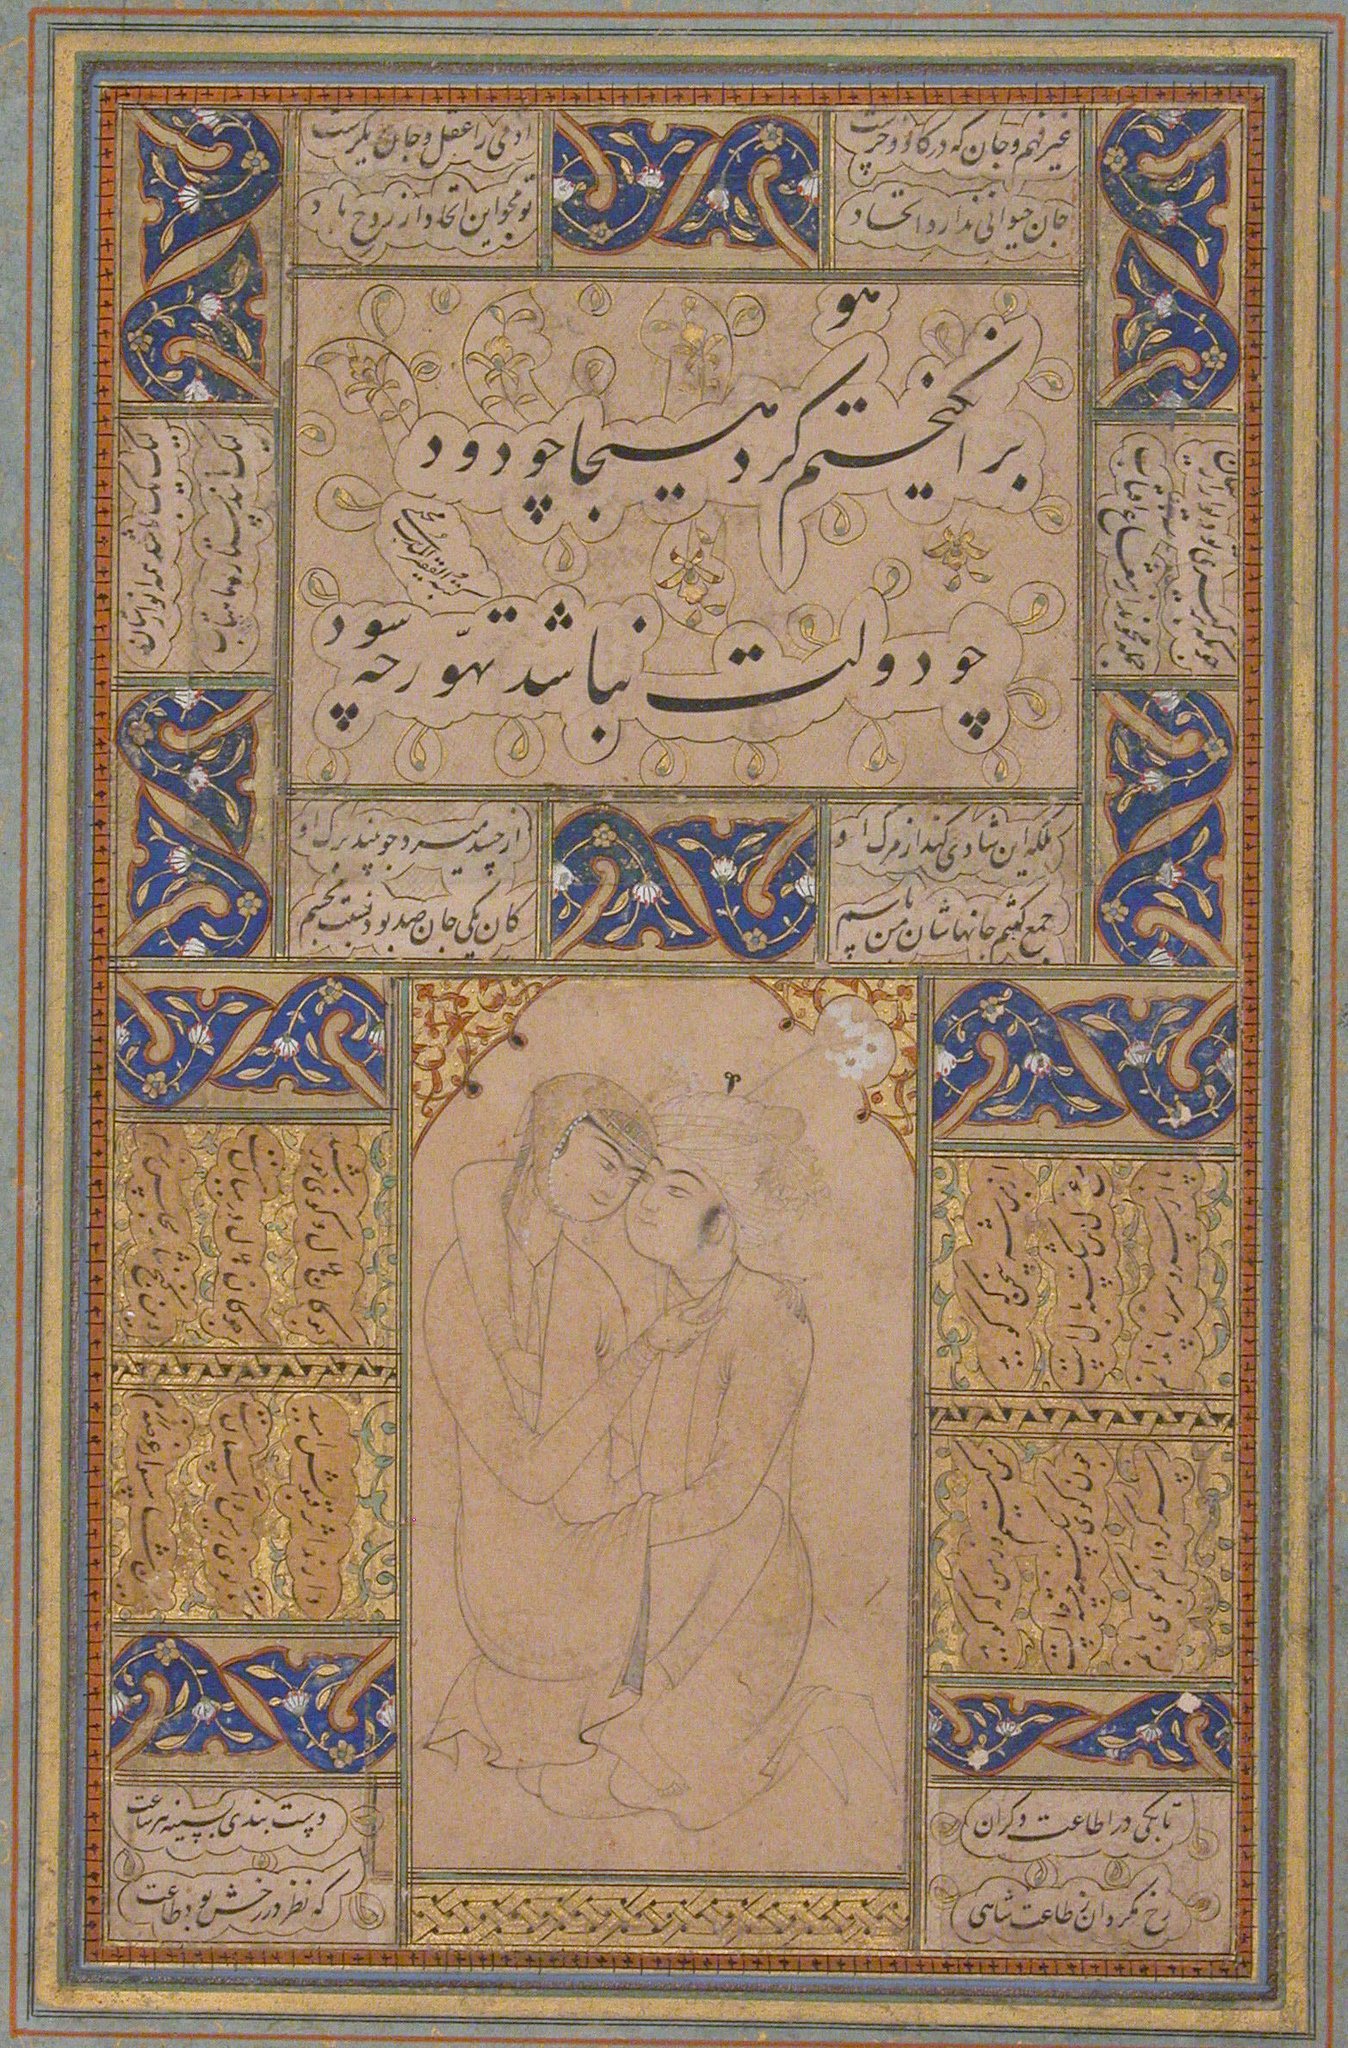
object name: illustrated single work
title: Young Lovers Embracing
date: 1501-1600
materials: gold, ink, paper, silver, watercolor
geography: iran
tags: men,lovers,women